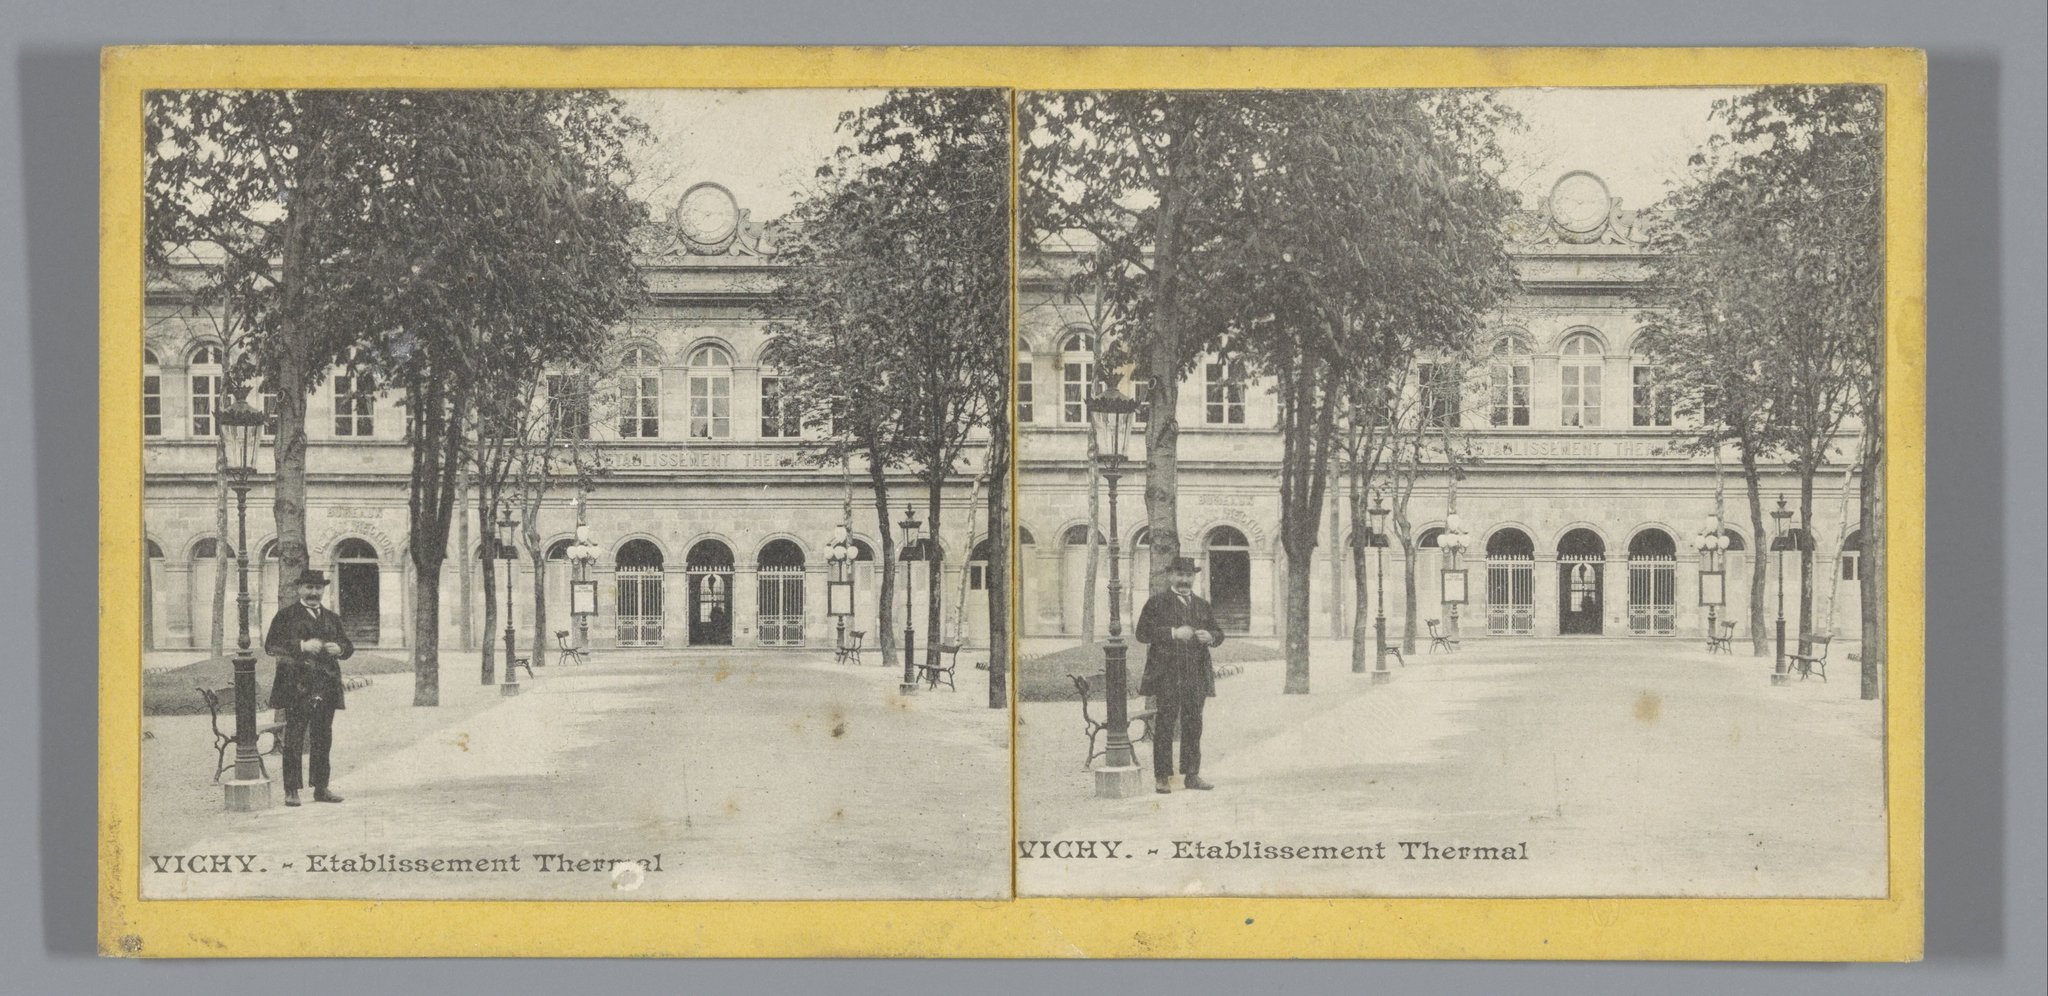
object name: stereograph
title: Gezicht op een thermaal instituut in Vichy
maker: Anonymous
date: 1890-1910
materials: cardboard, paper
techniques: photograph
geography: vichy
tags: watering-place, spa